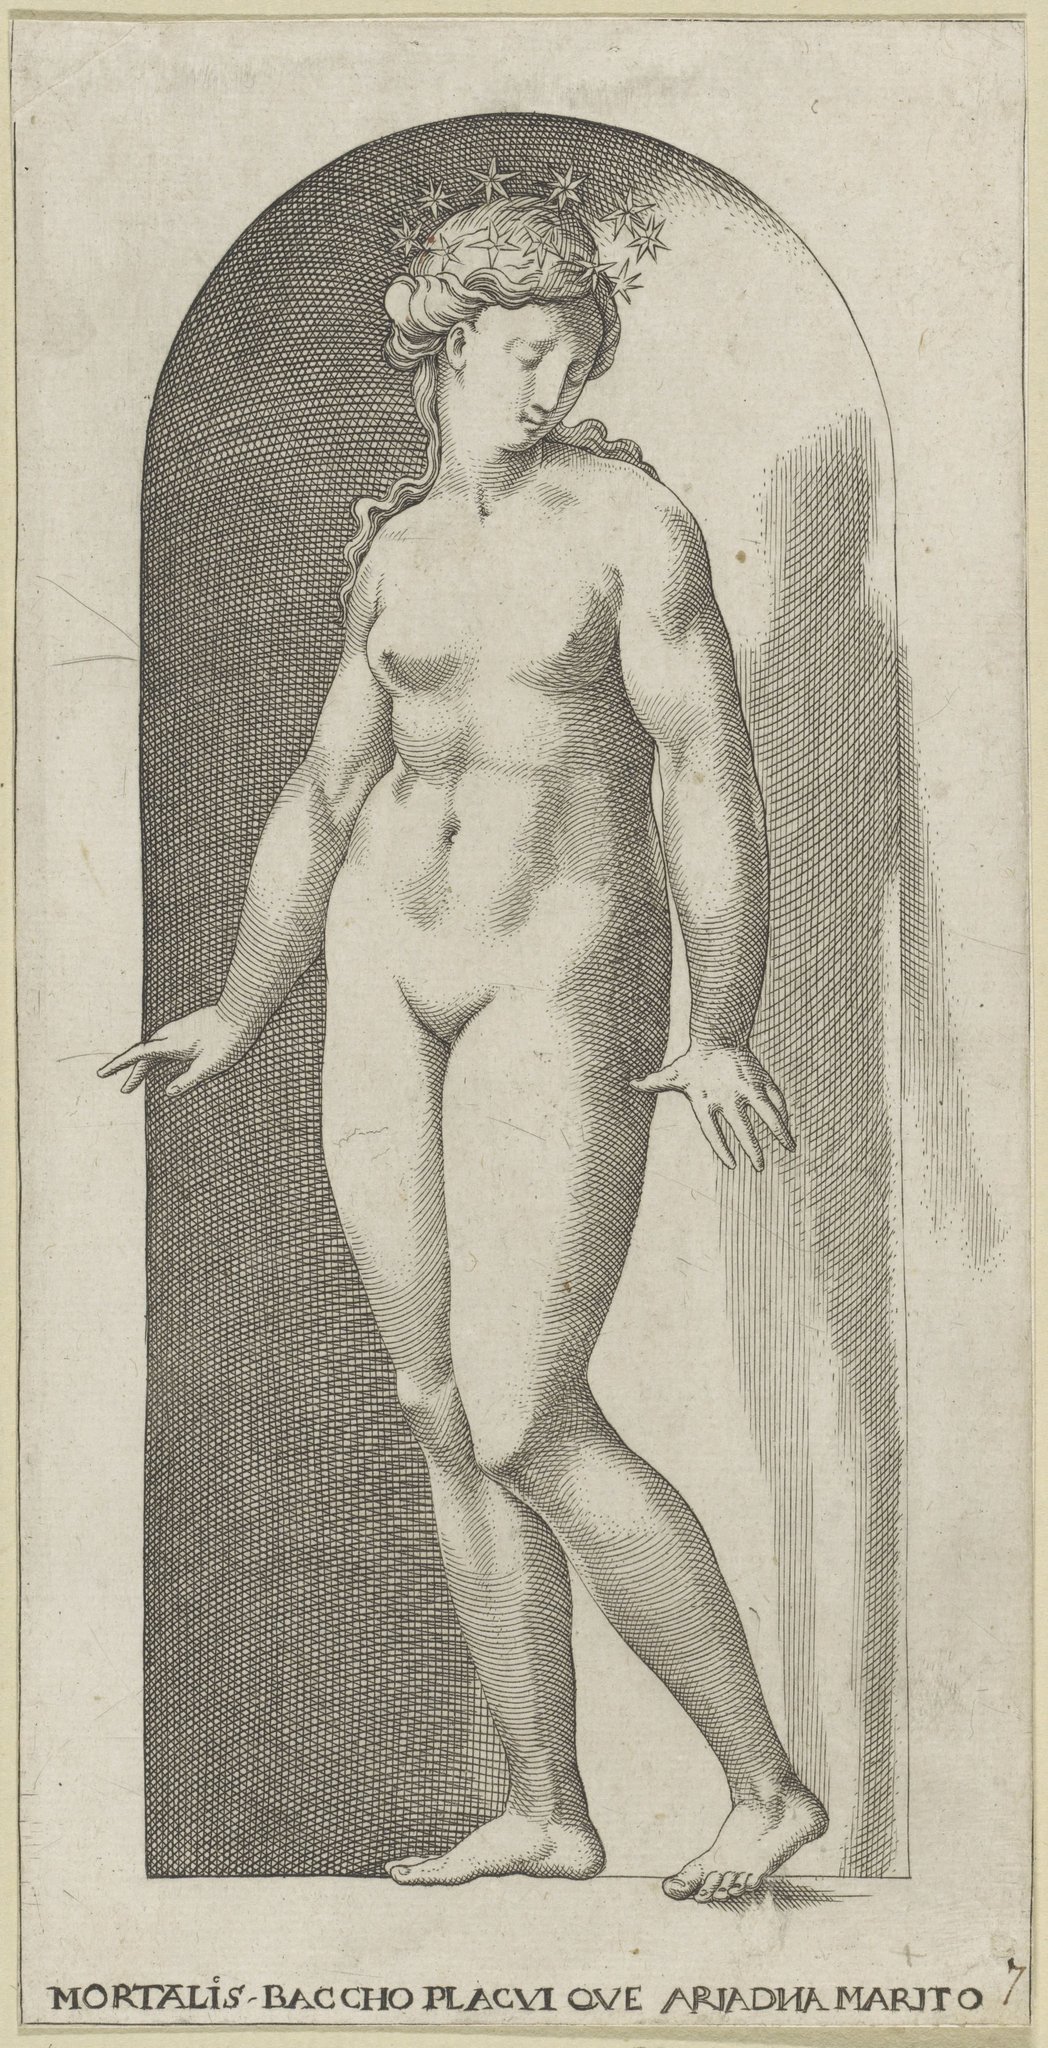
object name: print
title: Mortalis baccho placui que Ariadna marito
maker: jacob binck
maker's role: painter, print maker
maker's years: 1494-1569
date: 1510-1569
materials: paper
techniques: engraving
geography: italy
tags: (story of) ariadne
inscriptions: number: ‘7’, collector's mark: Lugt 11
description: De godin Ariadne staat met een kroon van sterren op in een nis.